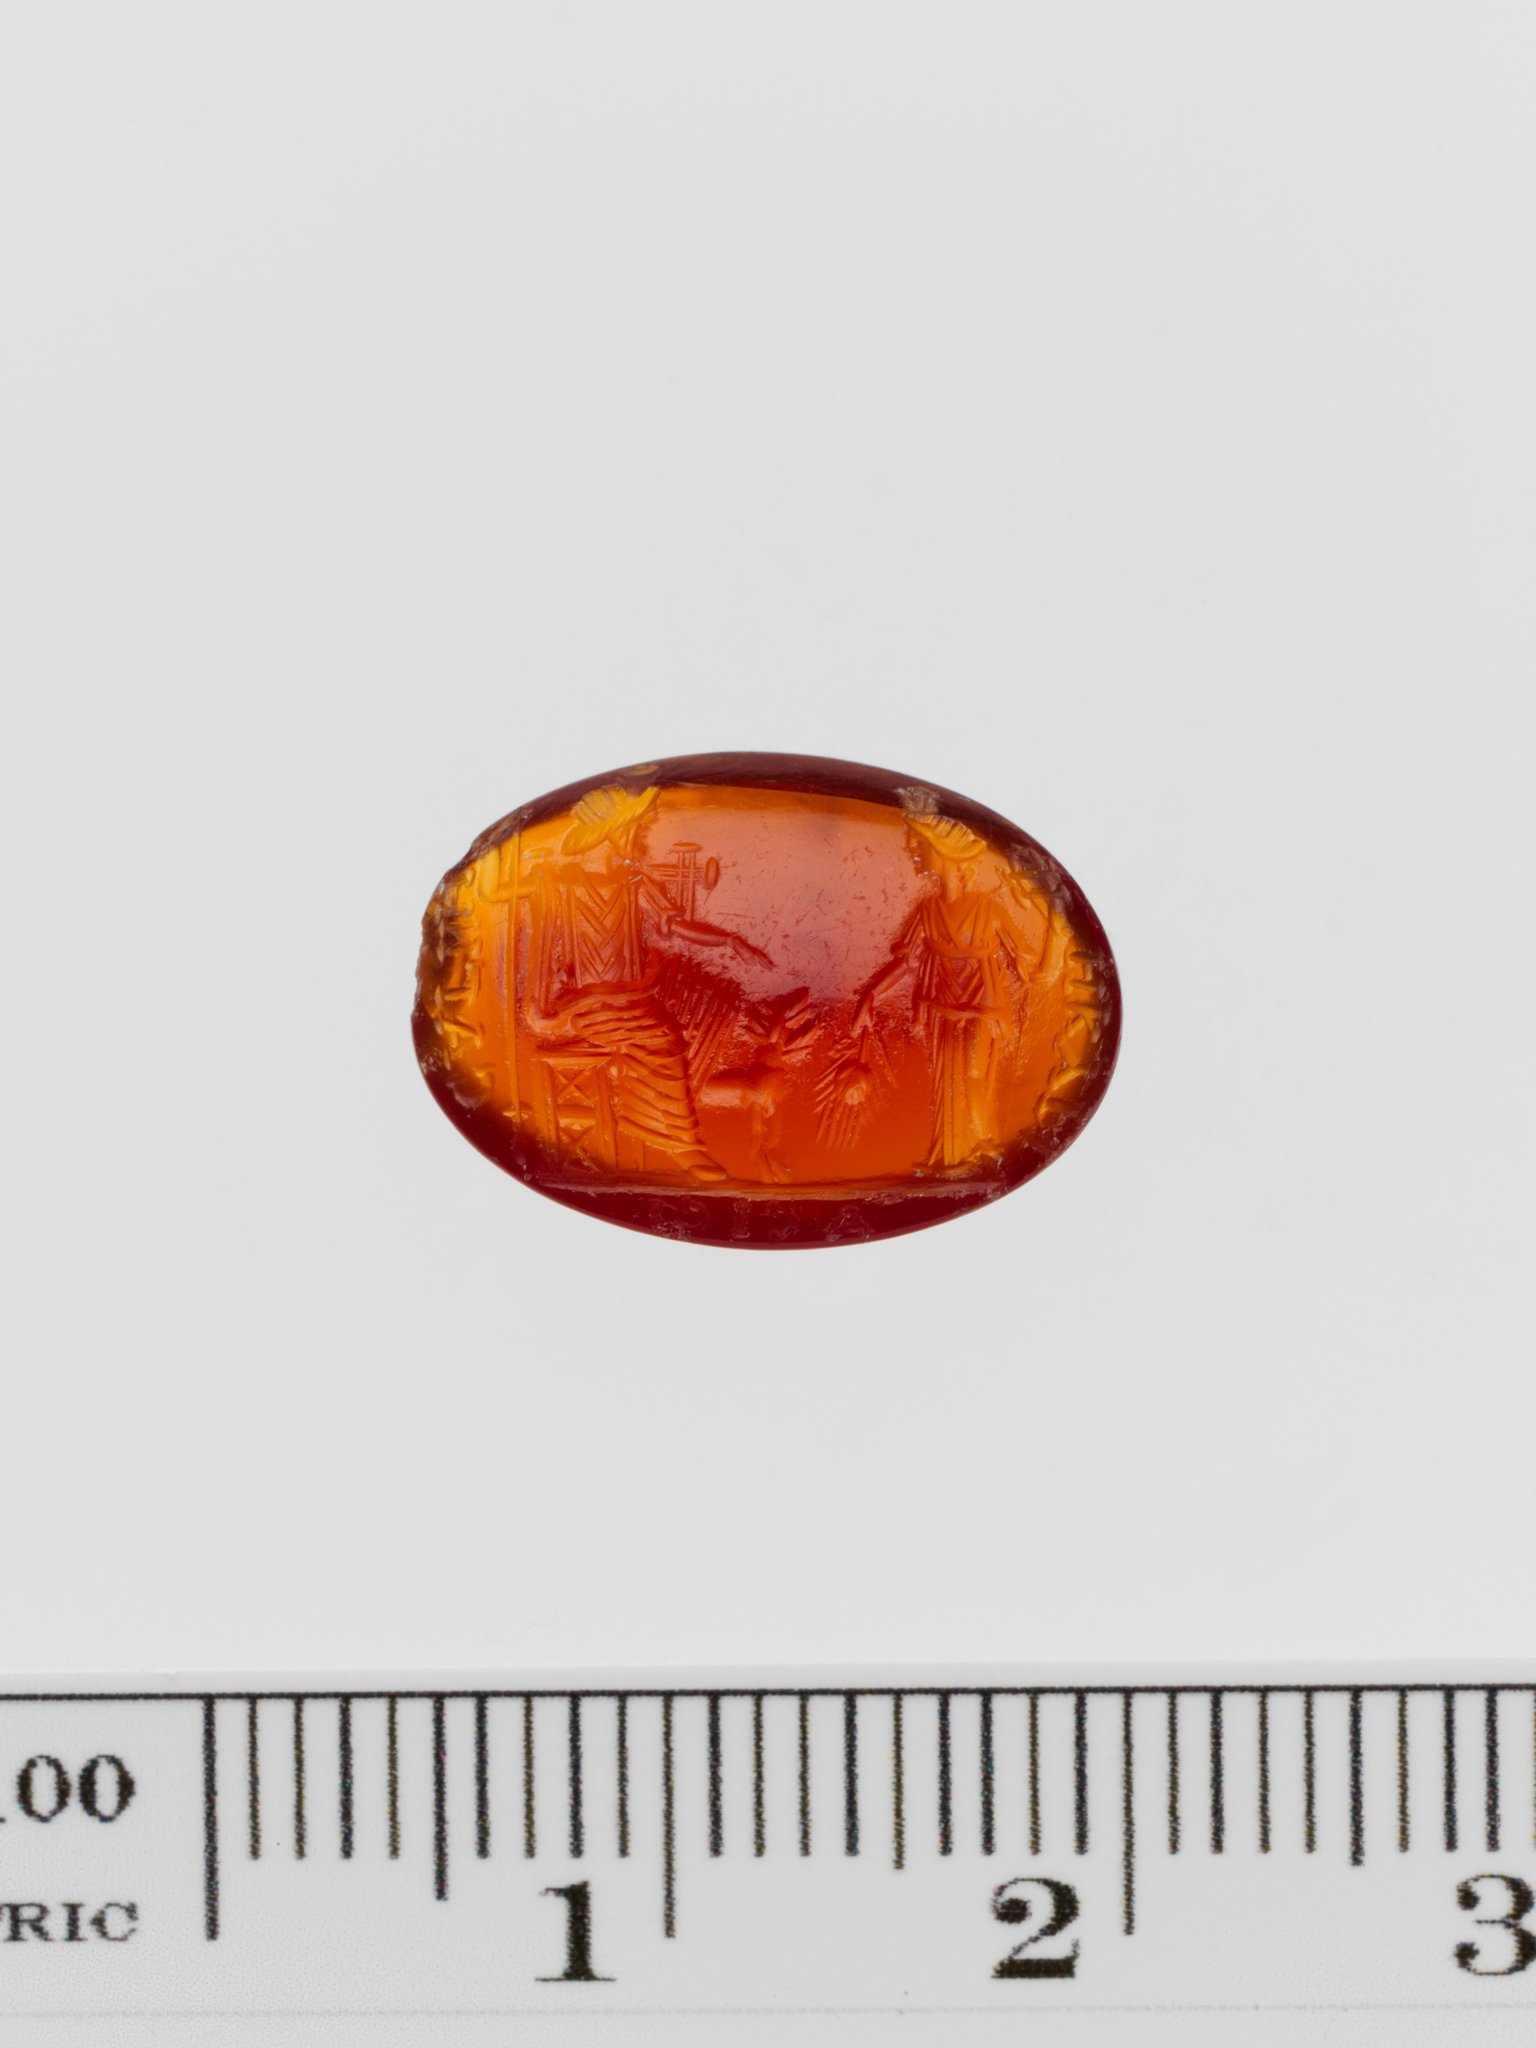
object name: intaglio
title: Carnelian ring stone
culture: roman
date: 1-200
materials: gemstone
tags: isis